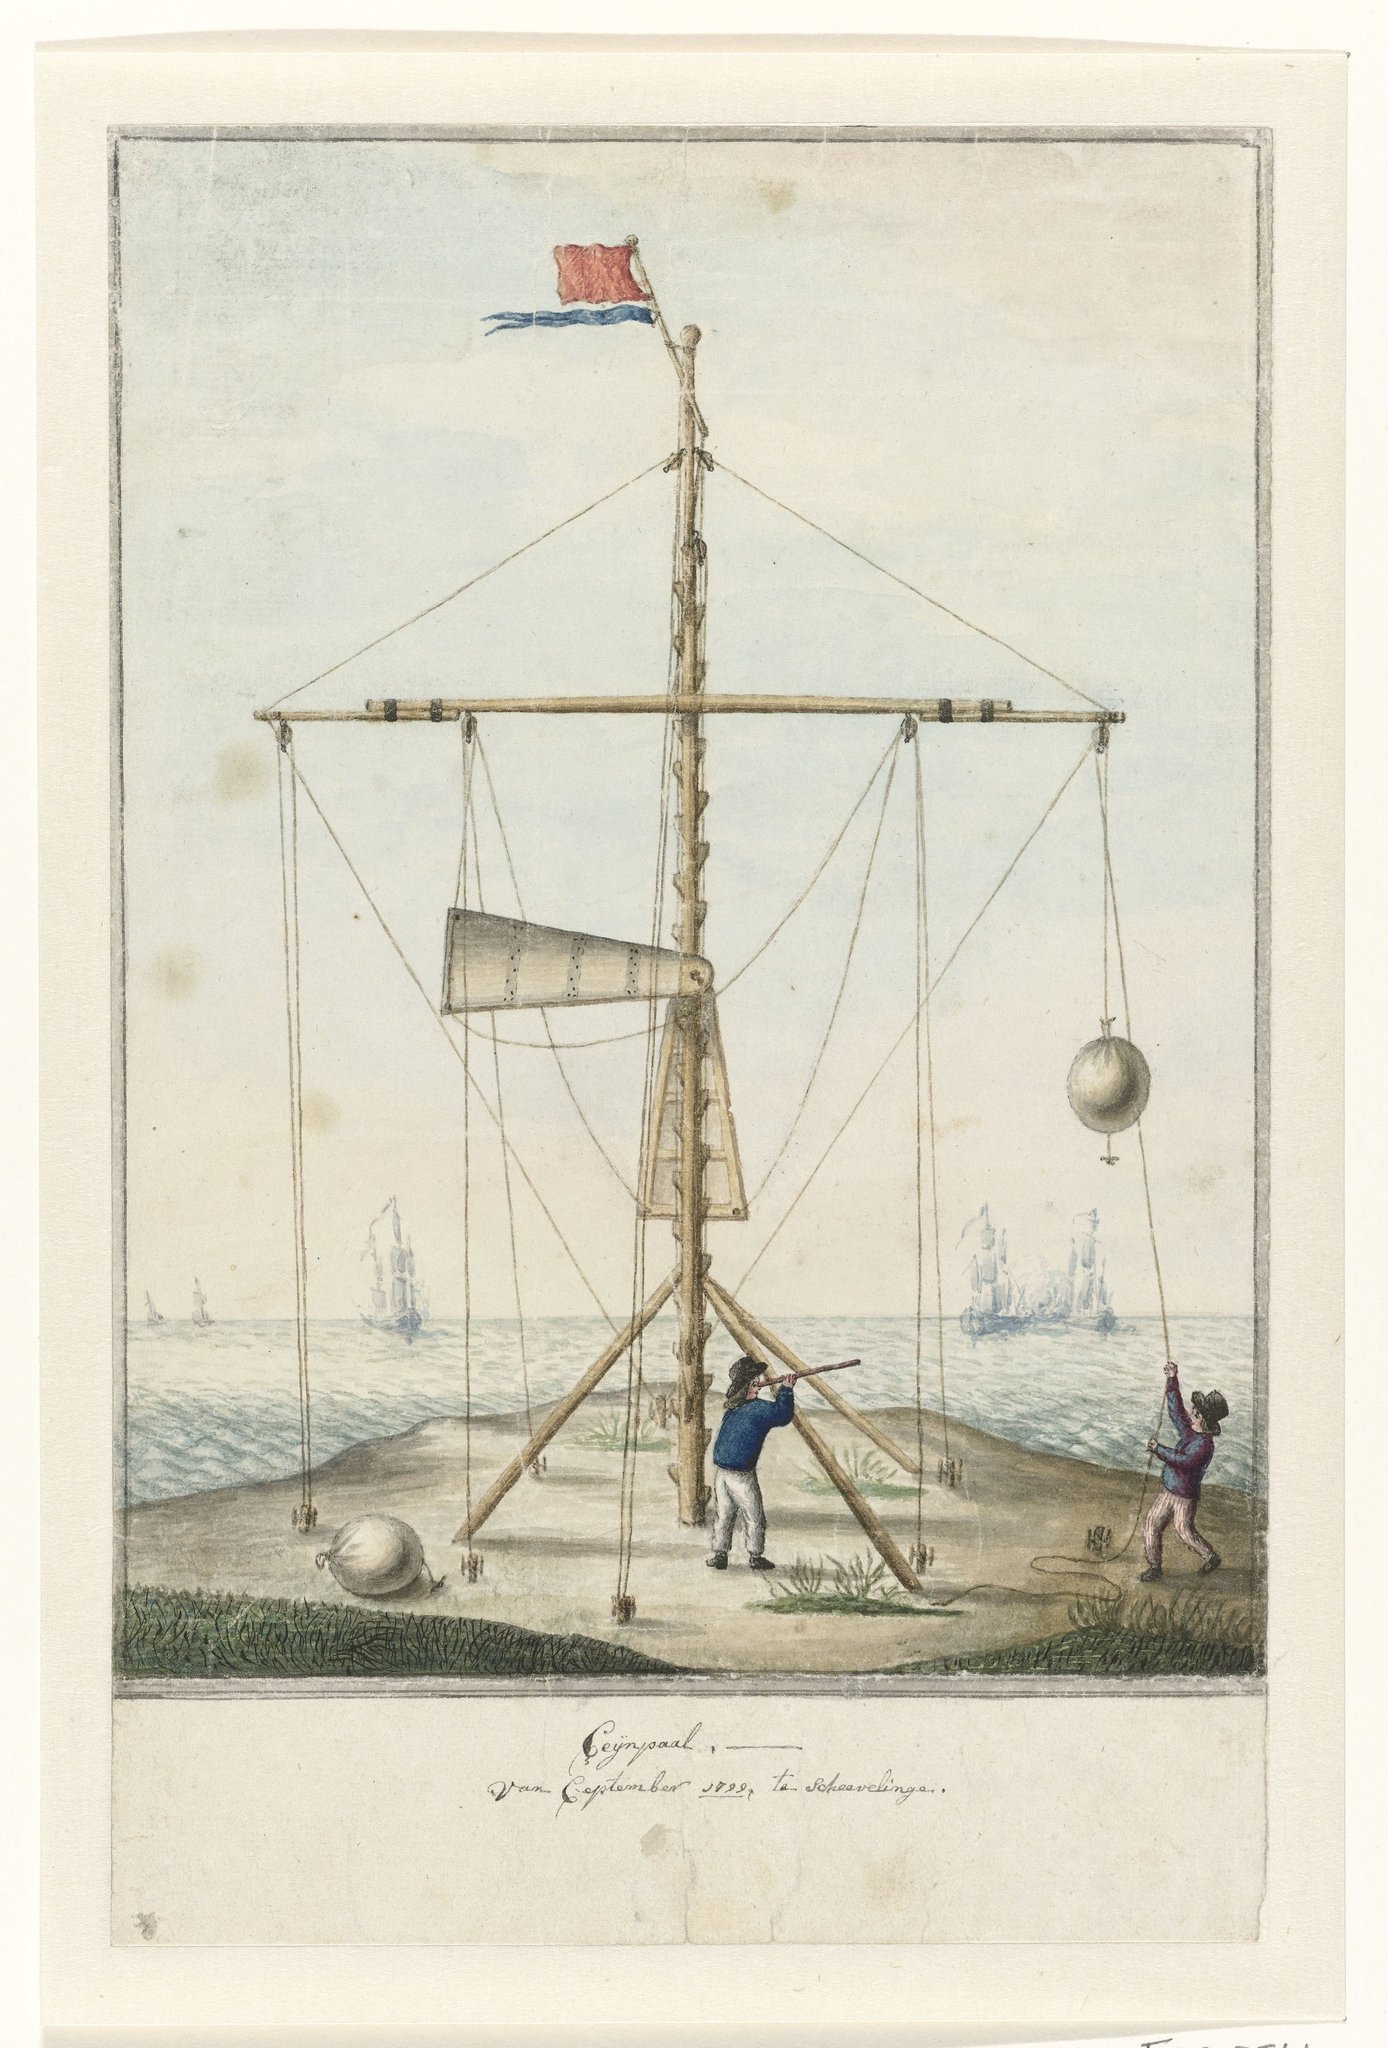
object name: drawing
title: Bataafse kusttelegraaf, 1799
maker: Anonymous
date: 1799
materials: paper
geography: netherlands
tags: semaphore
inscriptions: collector's mark: Lugt 2228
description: Bataafse kusttelegraaf, semafoor of seinpaal, opgesteld aan de kust bij Scheveningen, september 1799.